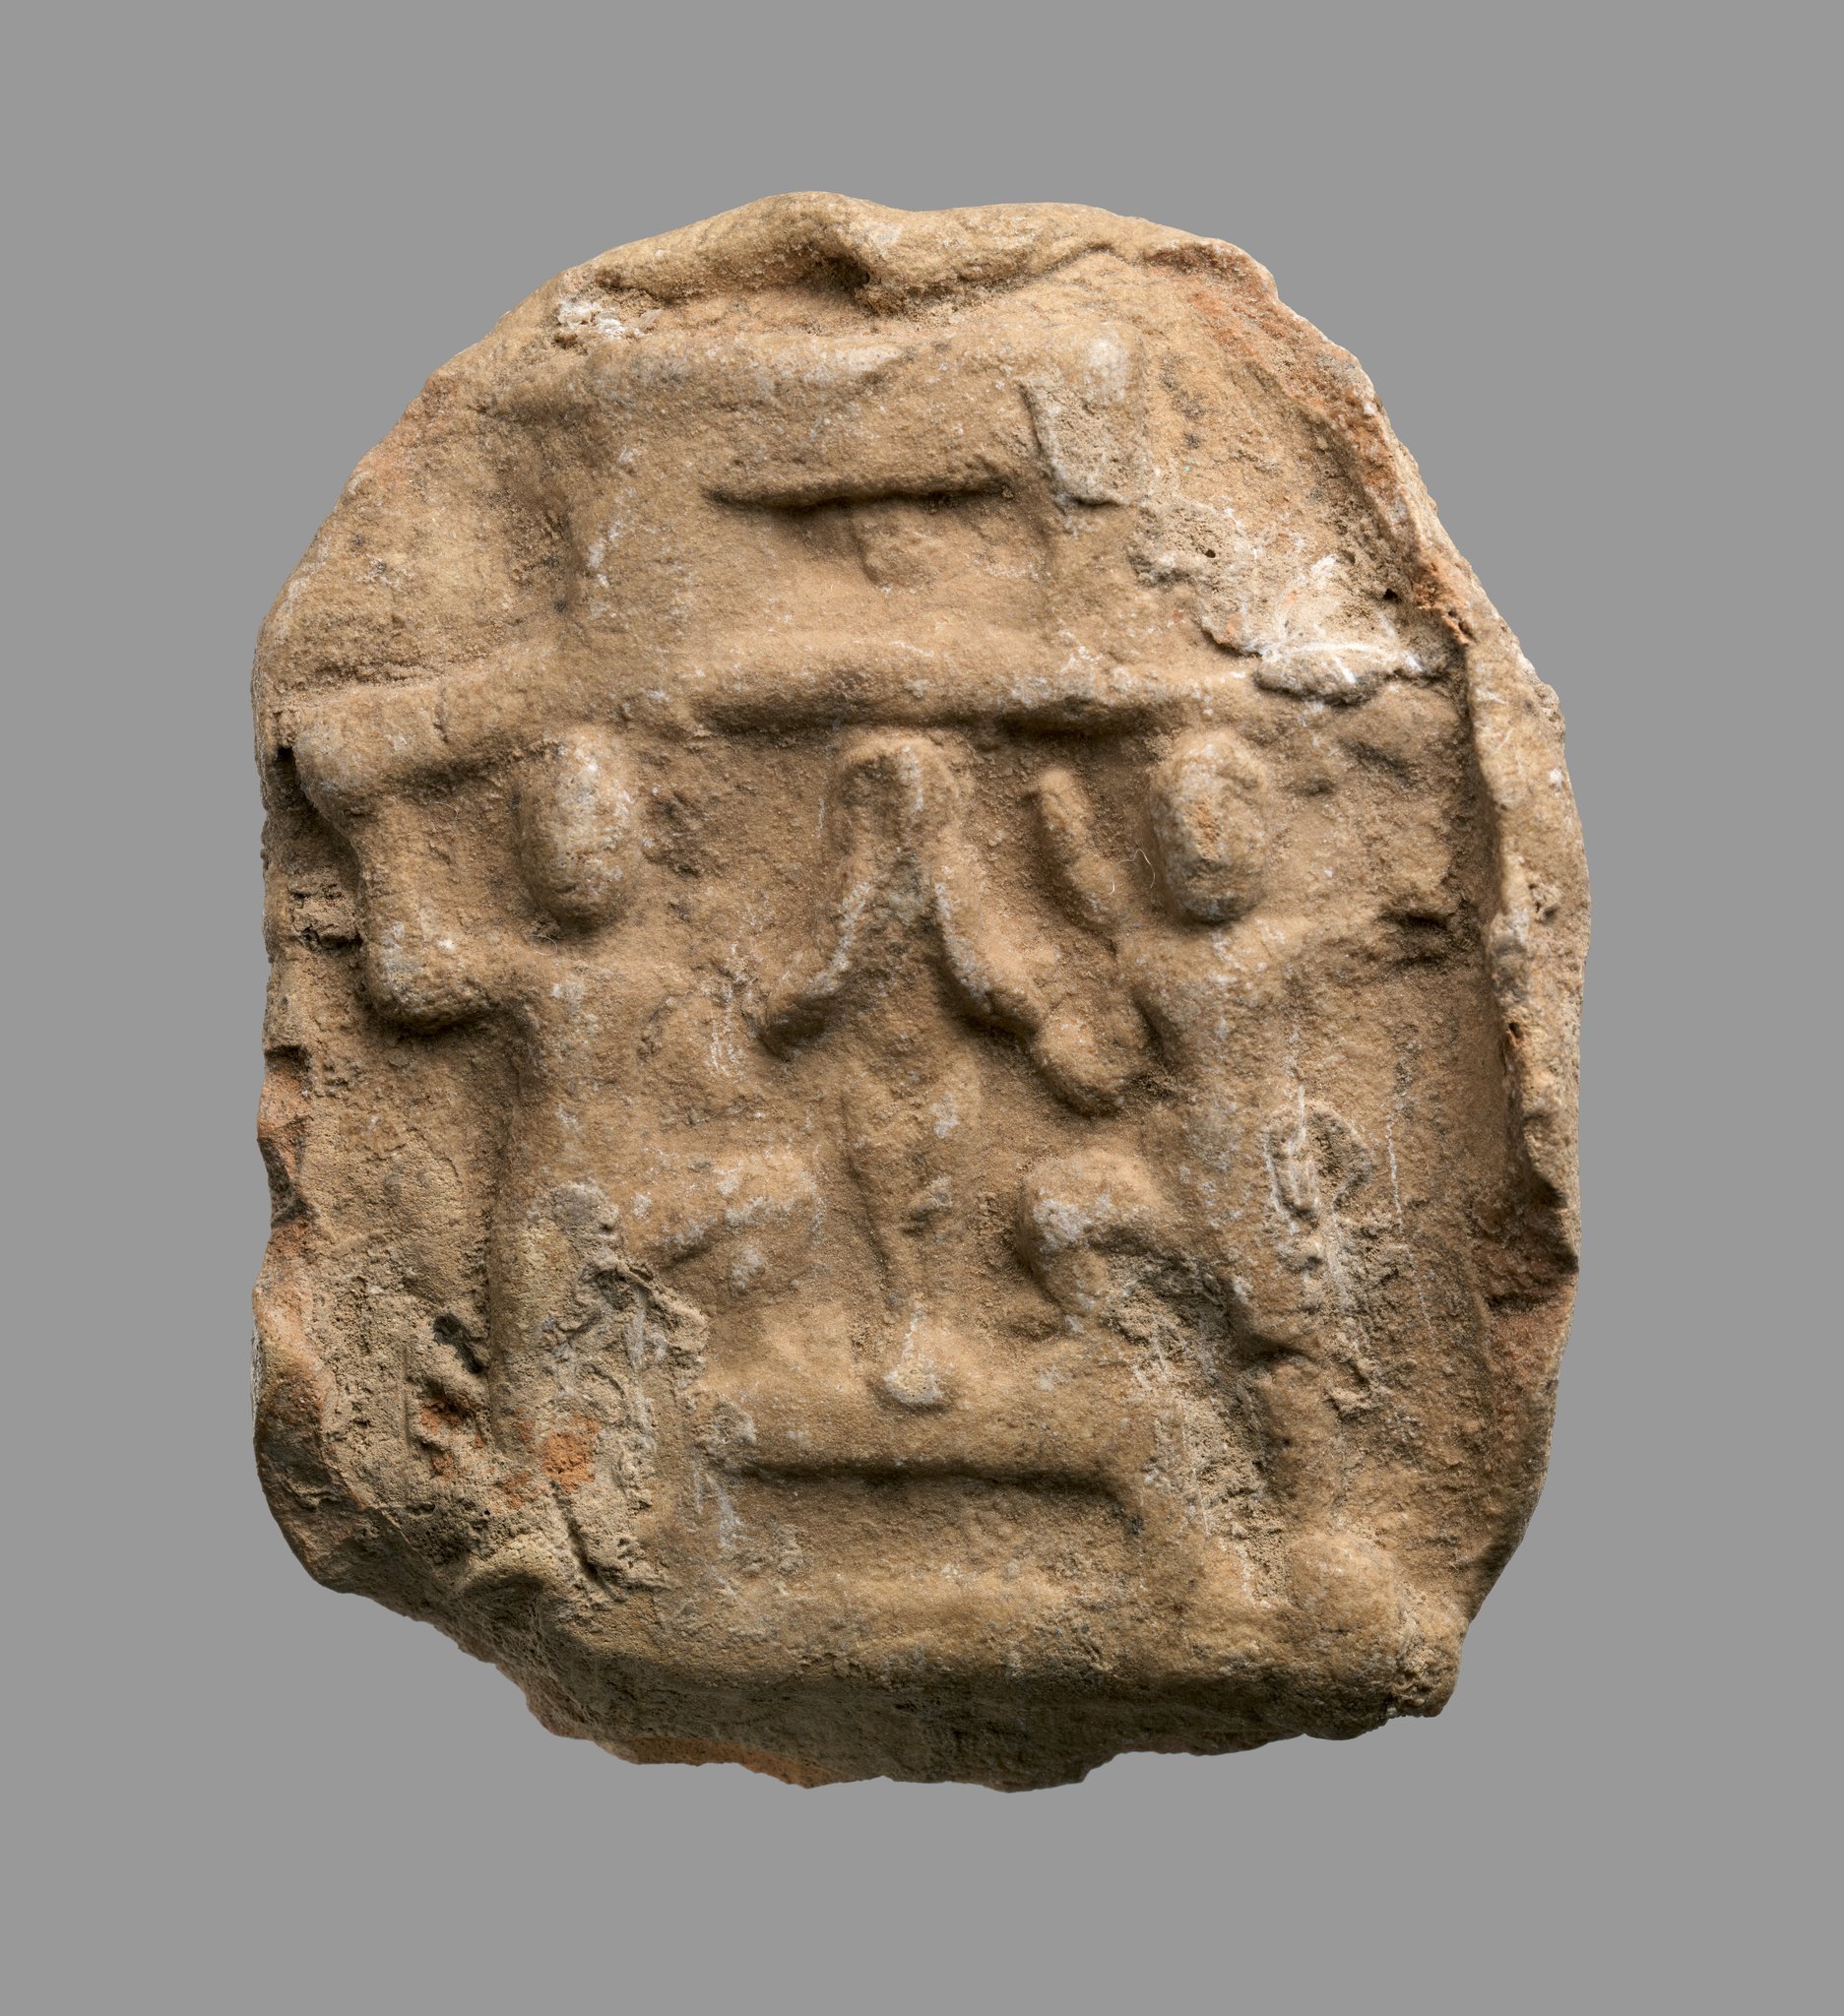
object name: relief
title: Ceramic imitation of bronze roller with two kilted figures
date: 2100-1750 BCE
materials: ceramic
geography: mesopotamia or syria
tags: men,women